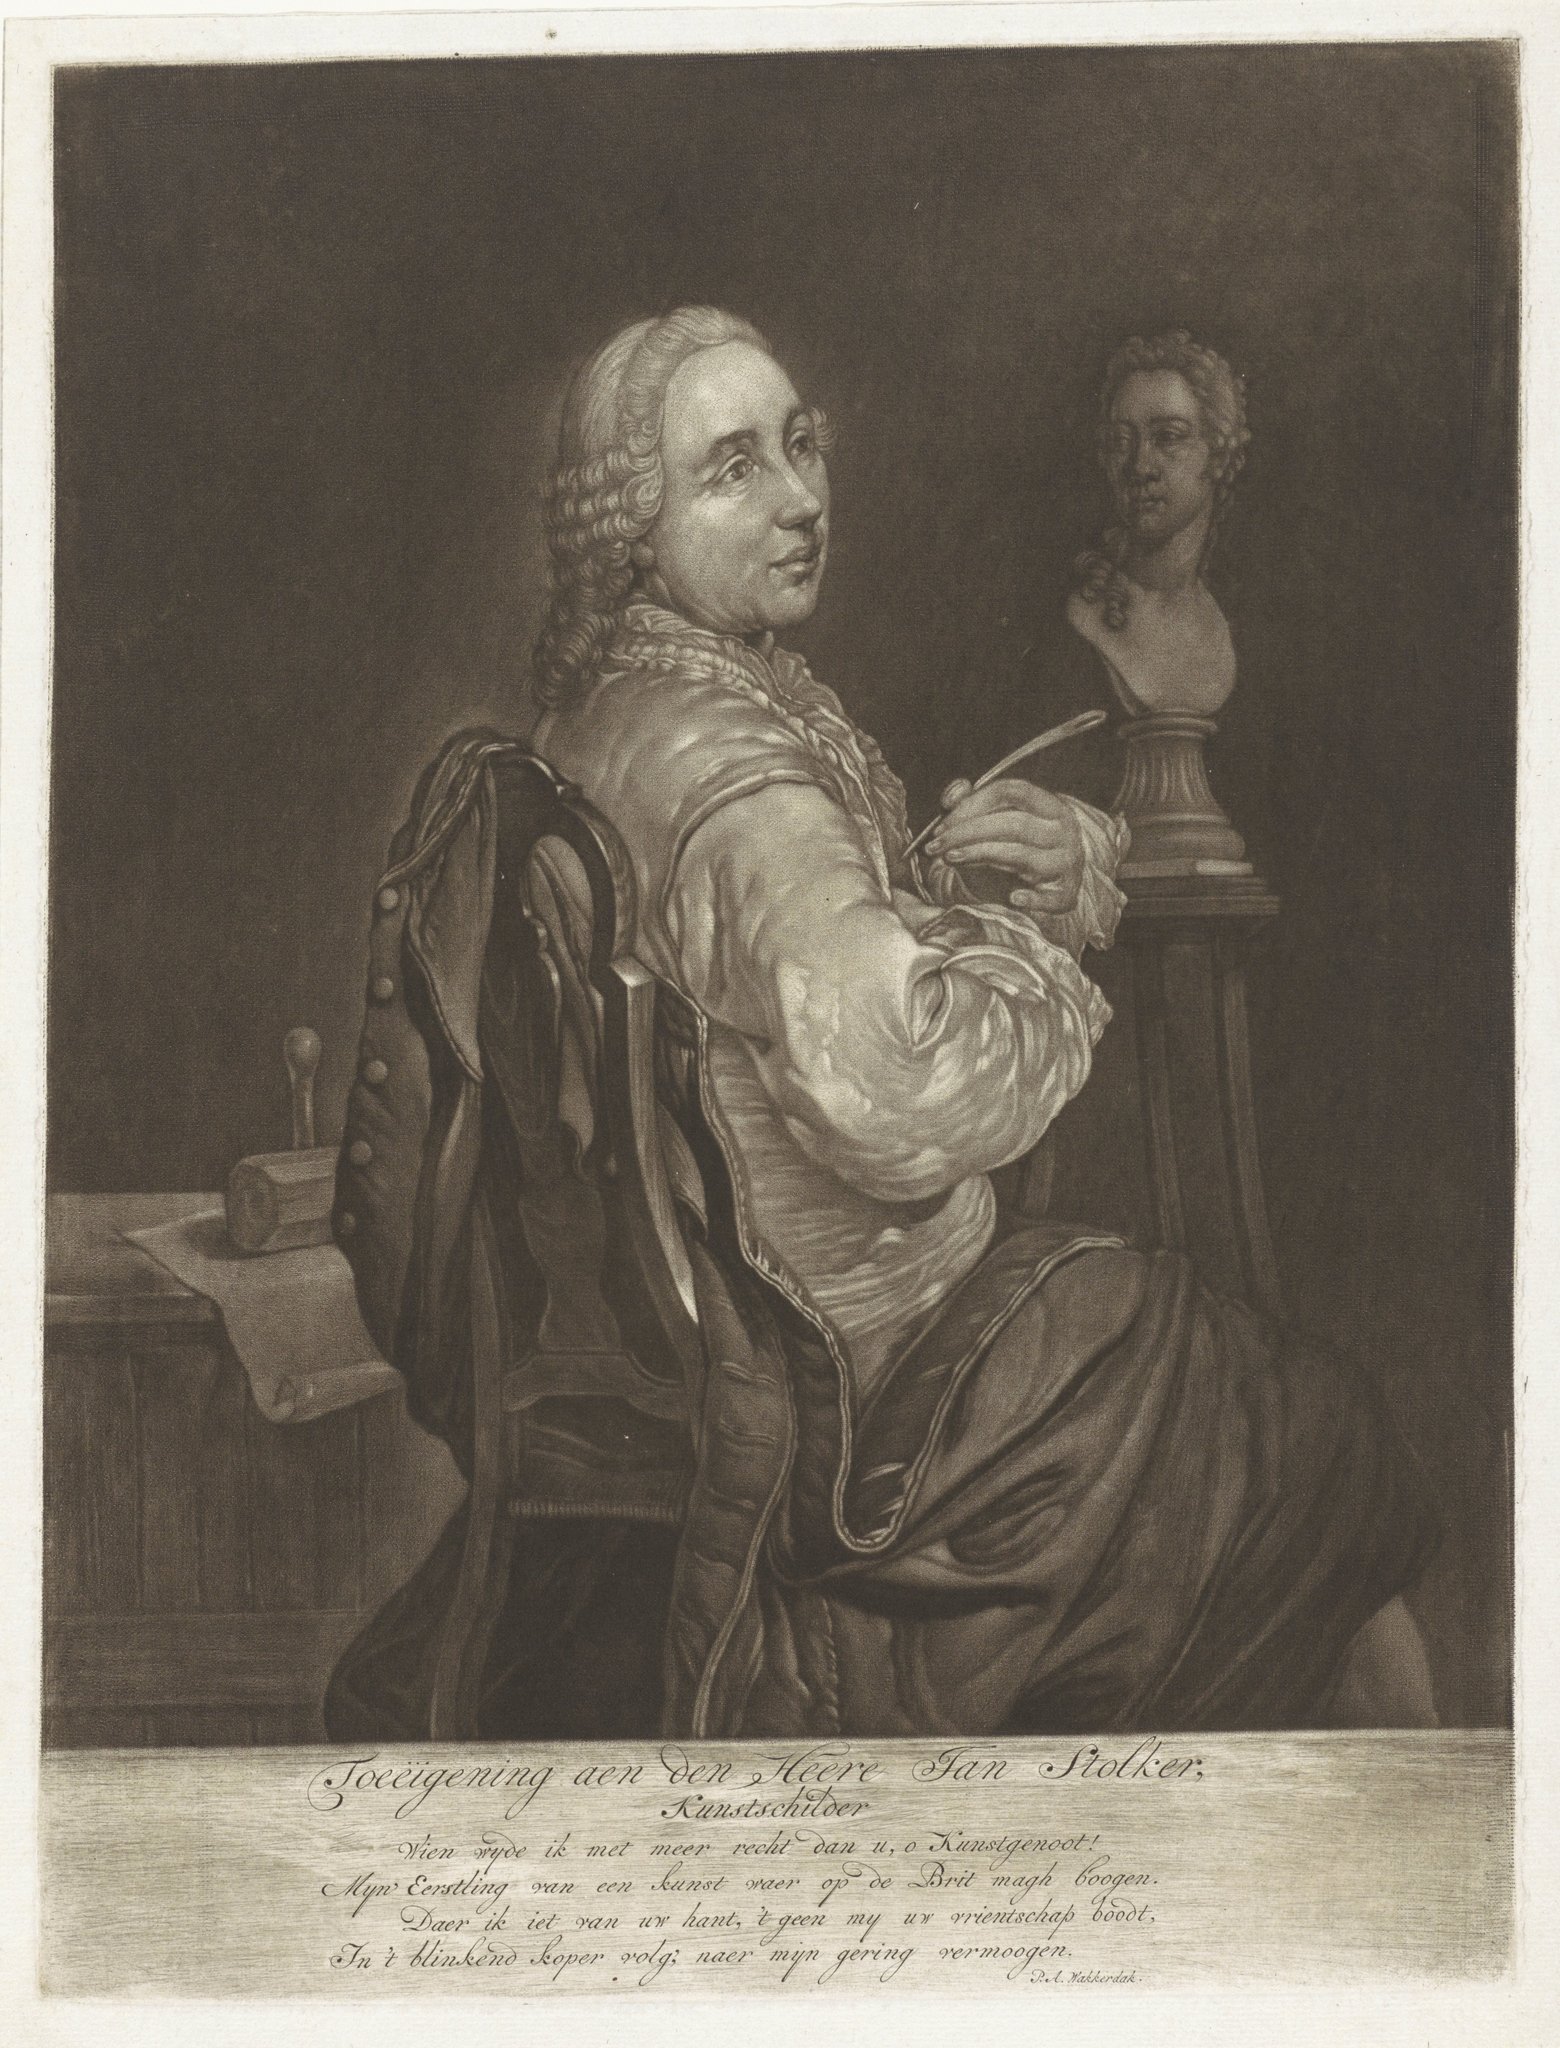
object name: print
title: Portret van Willem Dubbelens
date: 1739-1774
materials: paper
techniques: mezzotint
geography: rotterdam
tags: sculptor at work, piece of sculpture, reproduction of a piece of sculpture, wood carver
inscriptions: collector's mark: Lugt 2228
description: De houtsnijder Willem Dubbelens zit in een stoel voor een buste. In zijn hand heeft hij een instrument.